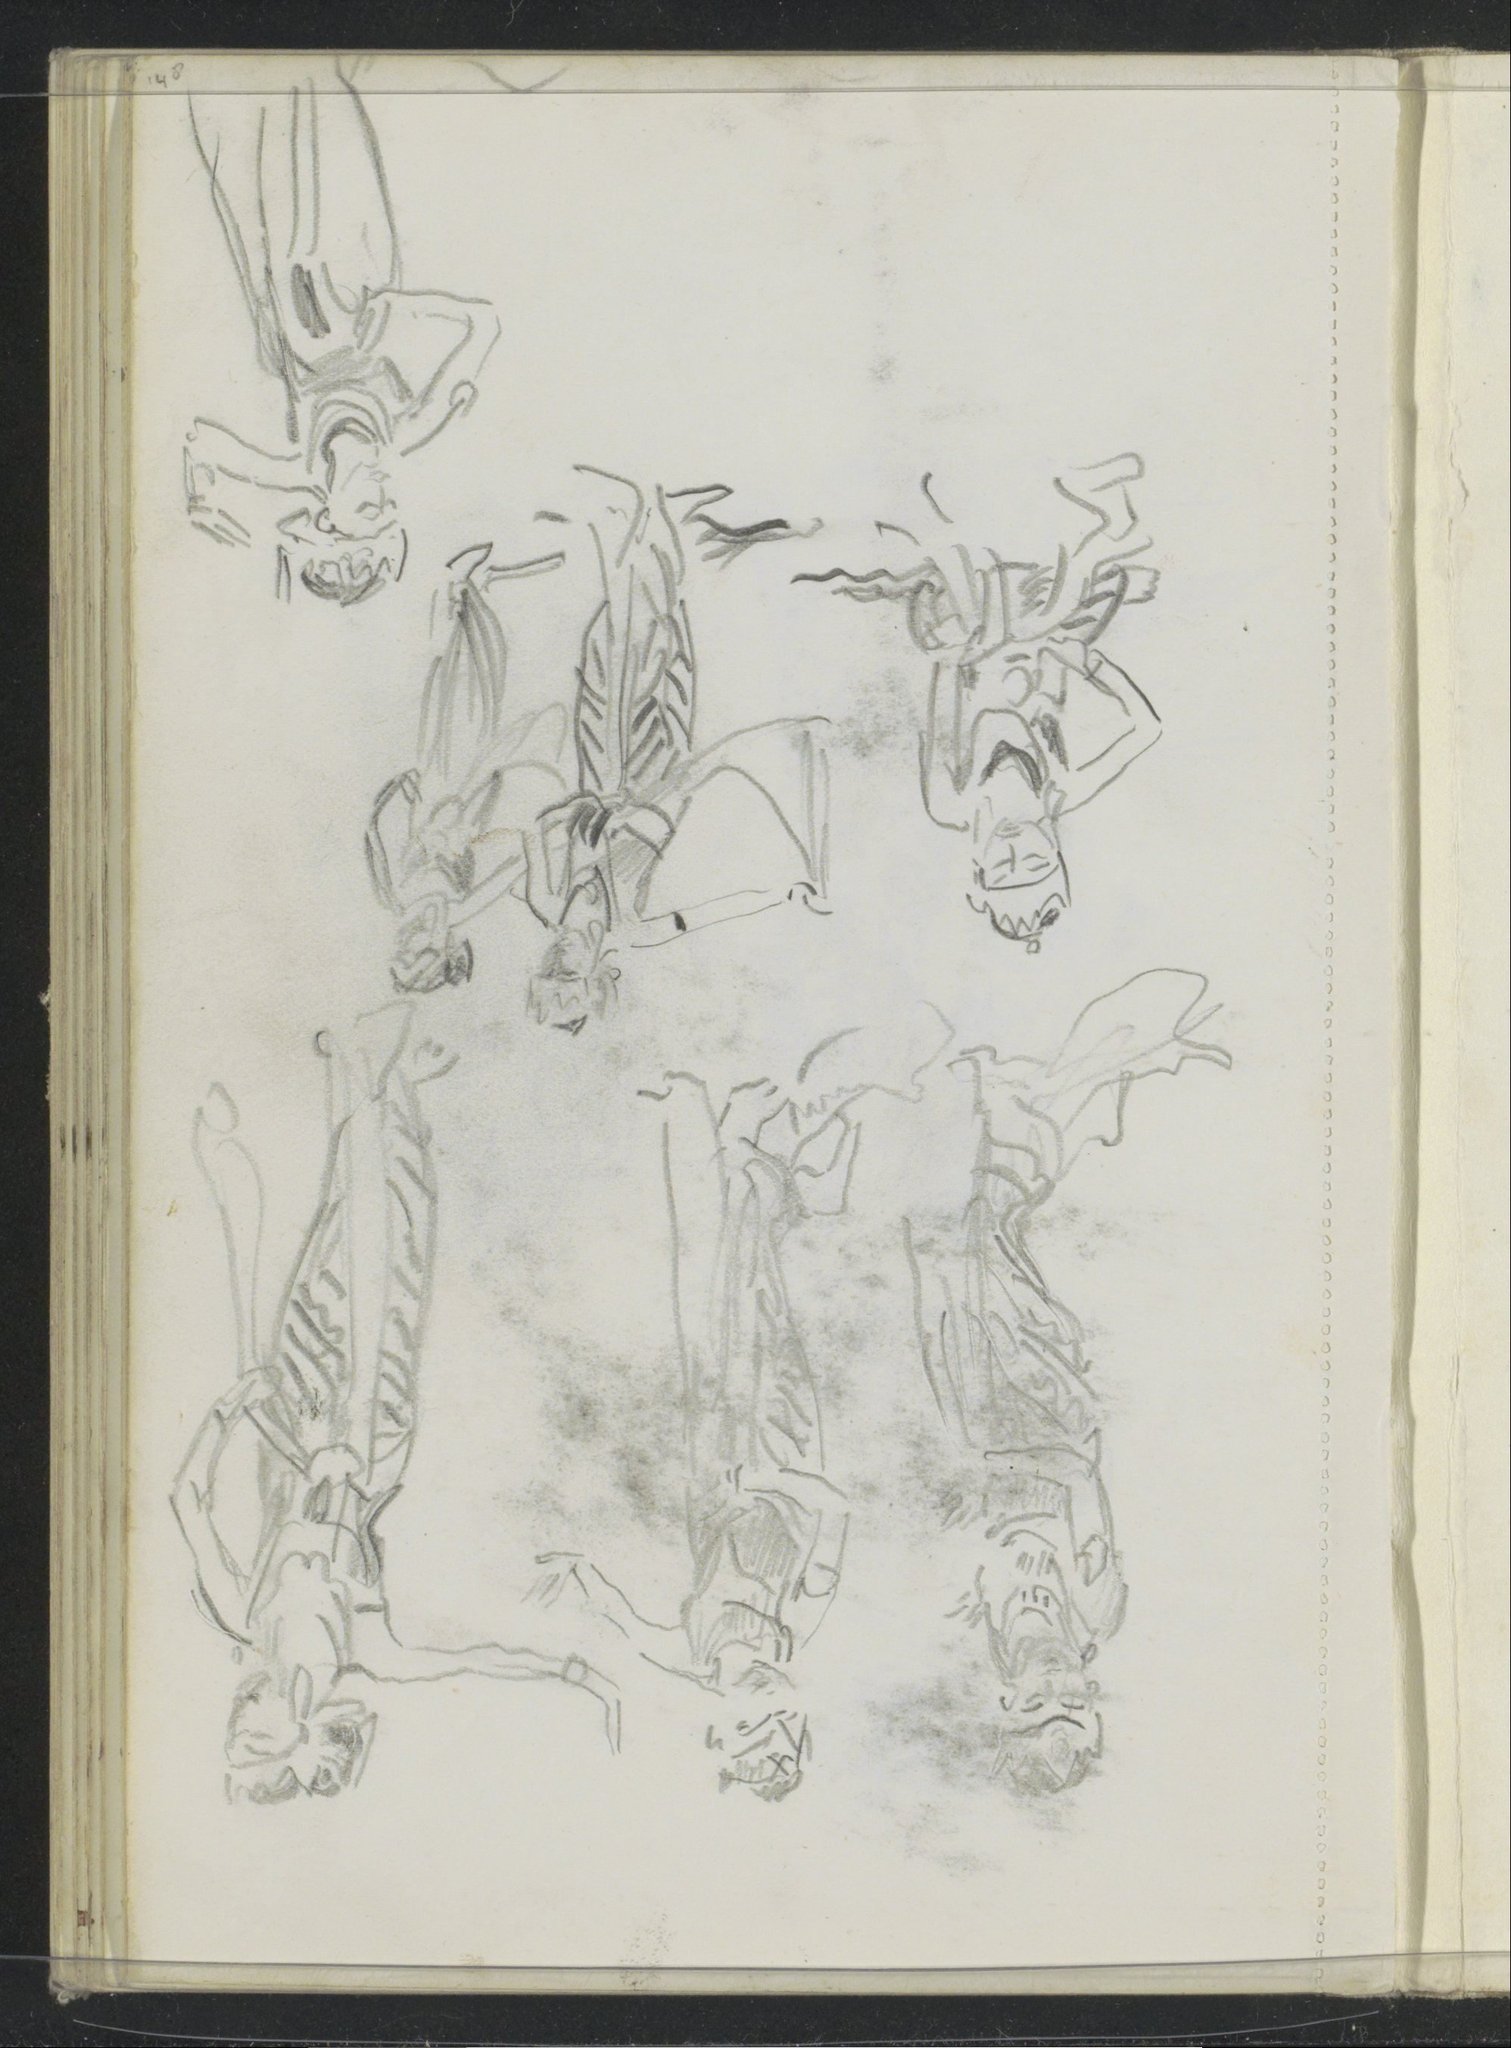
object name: sketchbook leaf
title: Dansende serimpies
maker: marius bauer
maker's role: draughtsman, print maker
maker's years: 1867-1932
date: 1925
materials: paper, pencil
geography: indonesia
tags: folk costume, regional costume, group of women (folk dancing)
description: Pagina 148 uit een schetsboek met 74 bladen.